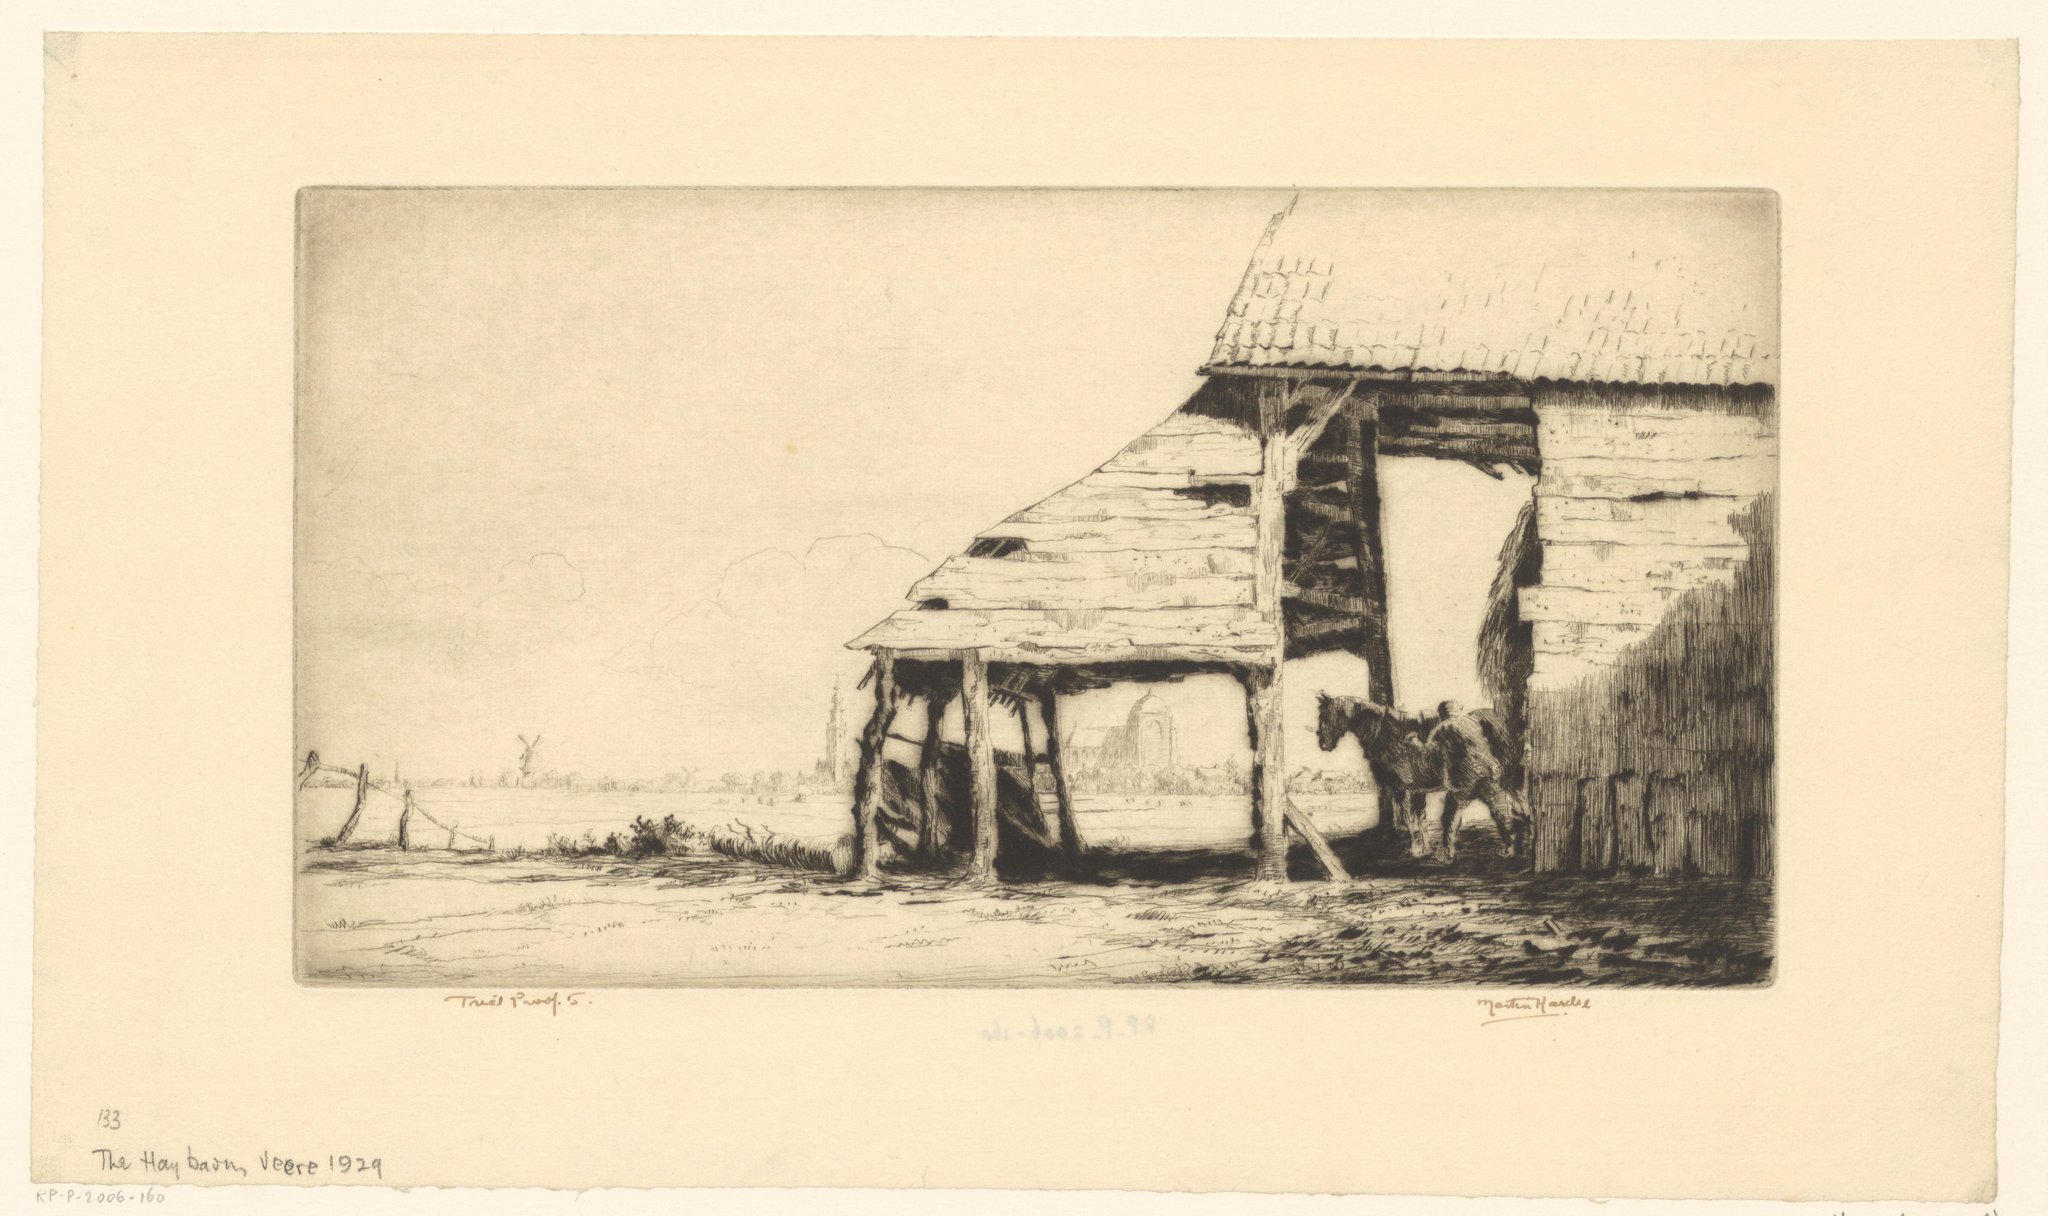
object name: print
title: Hooischuur met zicht op Veere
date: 1929-1945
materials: paper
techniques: drypoint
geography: veere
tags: barn, prospect of village, silhouette of village (+ city(-scape) with figures, staffage)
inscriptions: collector's mark: Lugt 2228, annotation: ‘Martin Hardie’, collector's mark: Lugt 2760, annotation: ‘Trial Proof 5’